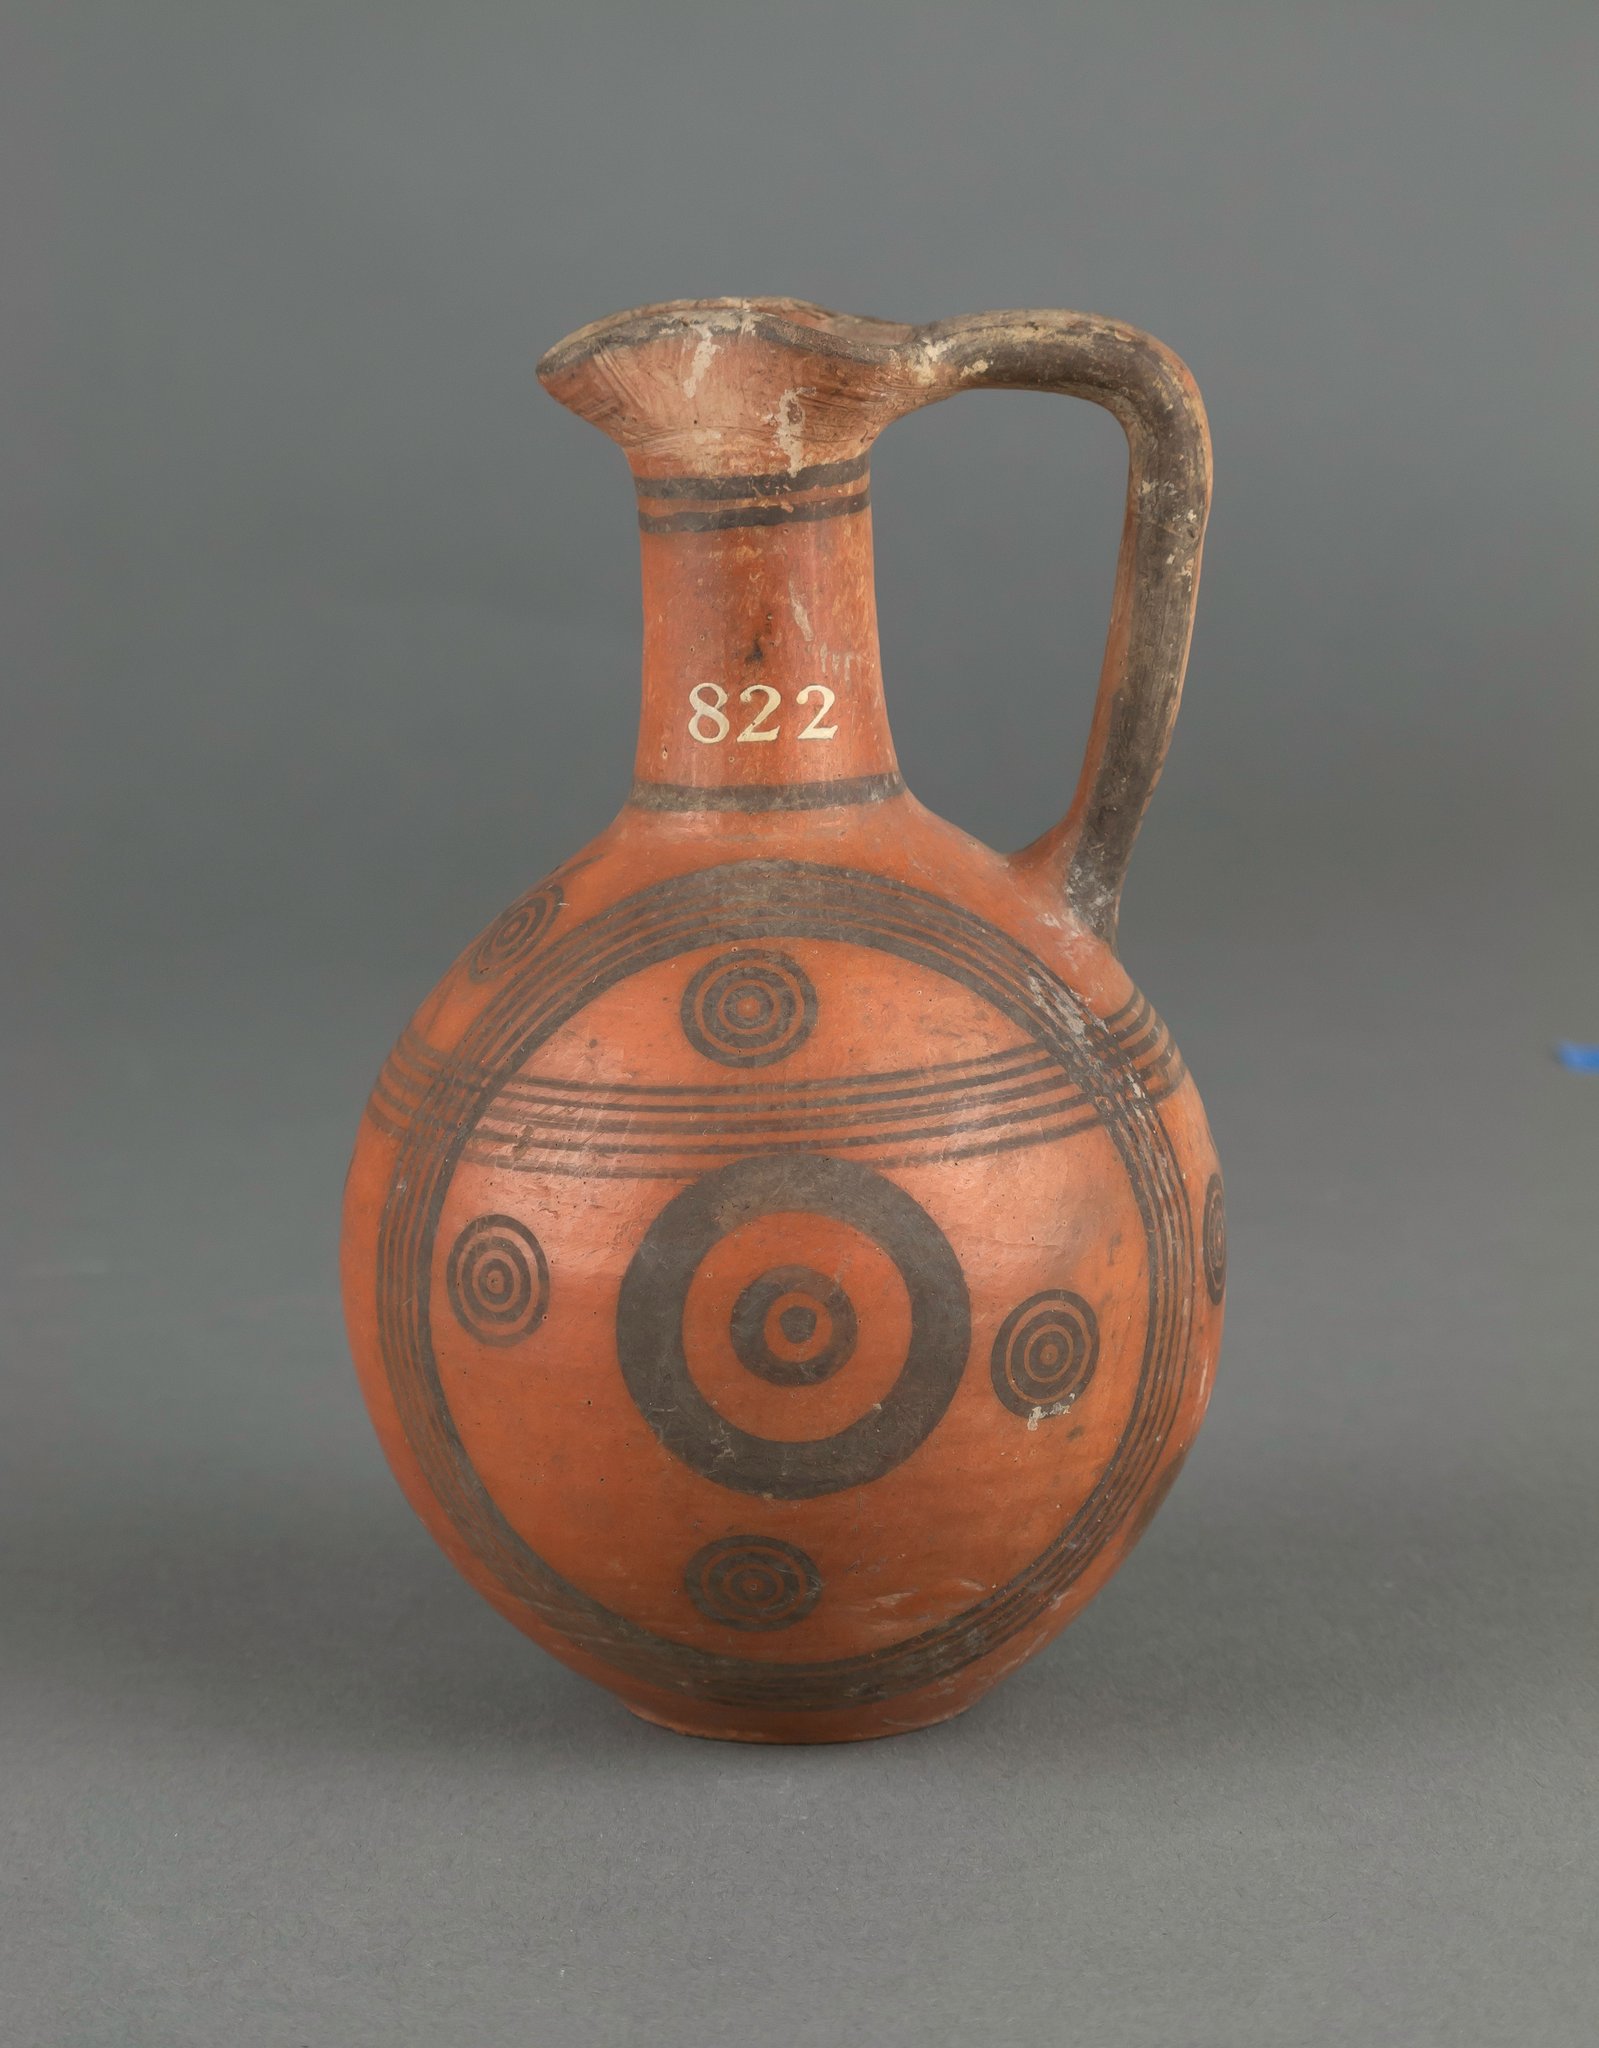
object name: jug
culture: cypriot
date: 750-600 BCE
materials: terracotta